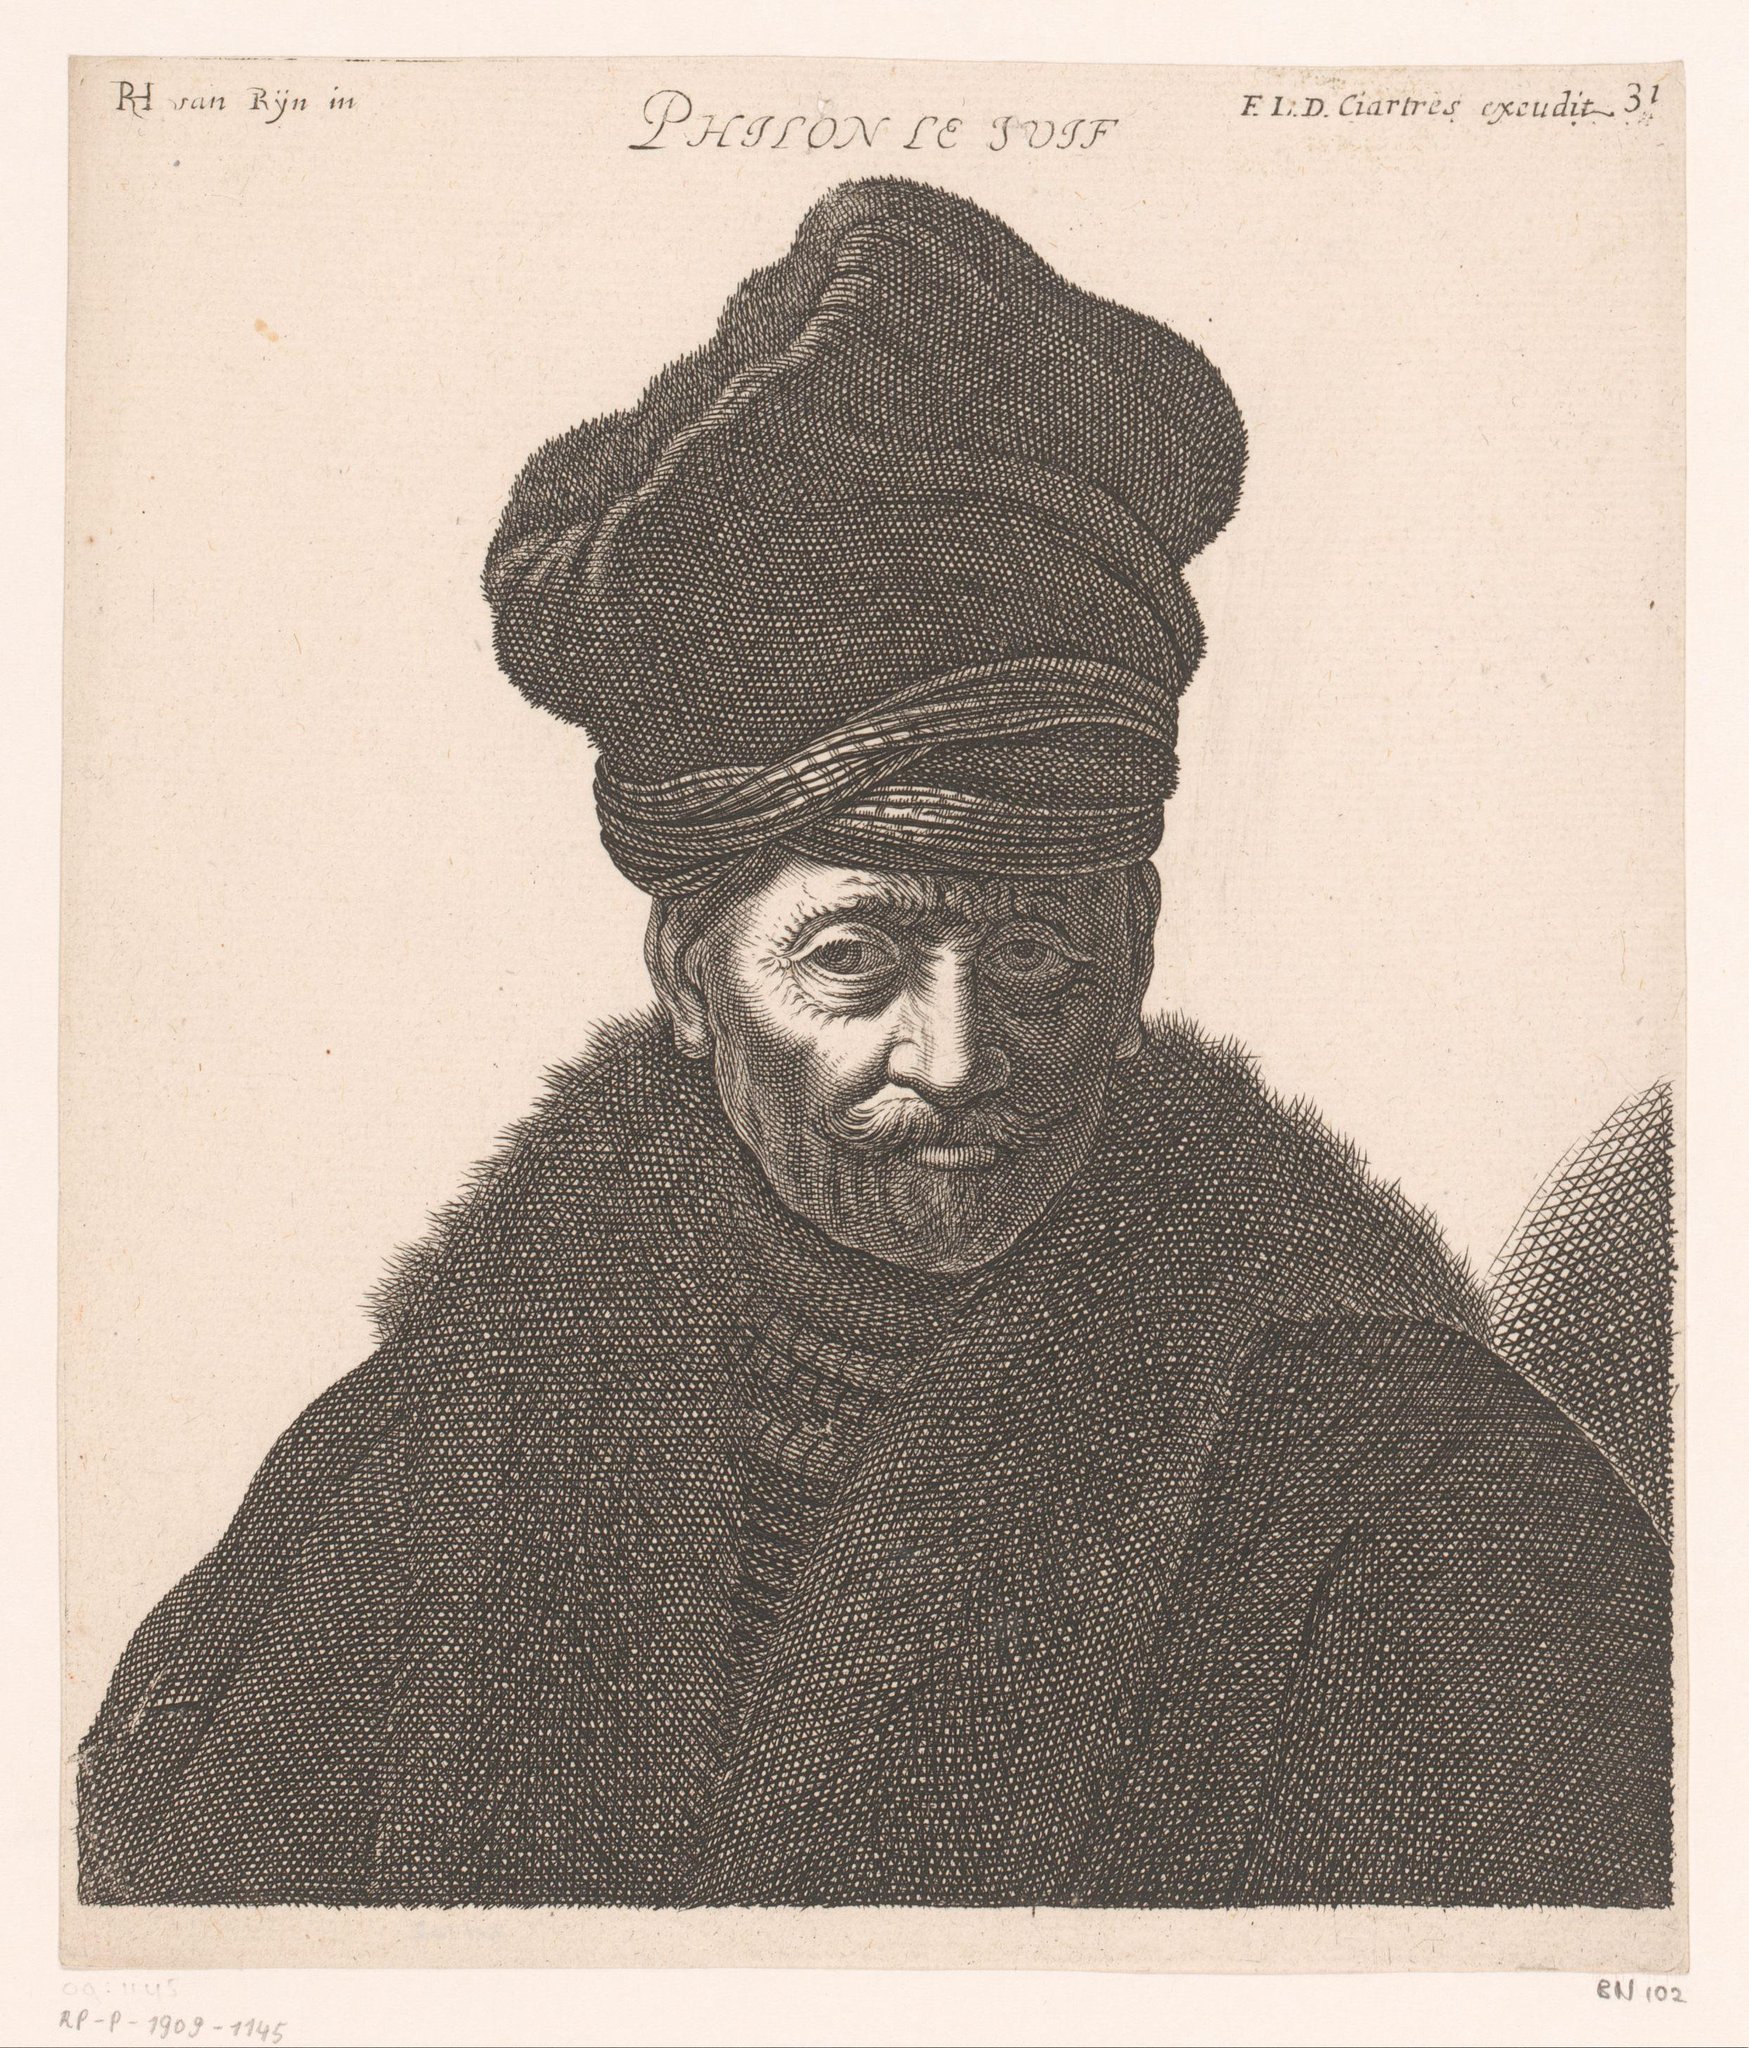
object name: print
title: Philon le Juif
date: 1615-1647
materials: paper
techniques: engraving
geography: paris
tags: scholar, philosopher, historical persons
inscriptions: collector's mark: Lugt 2228